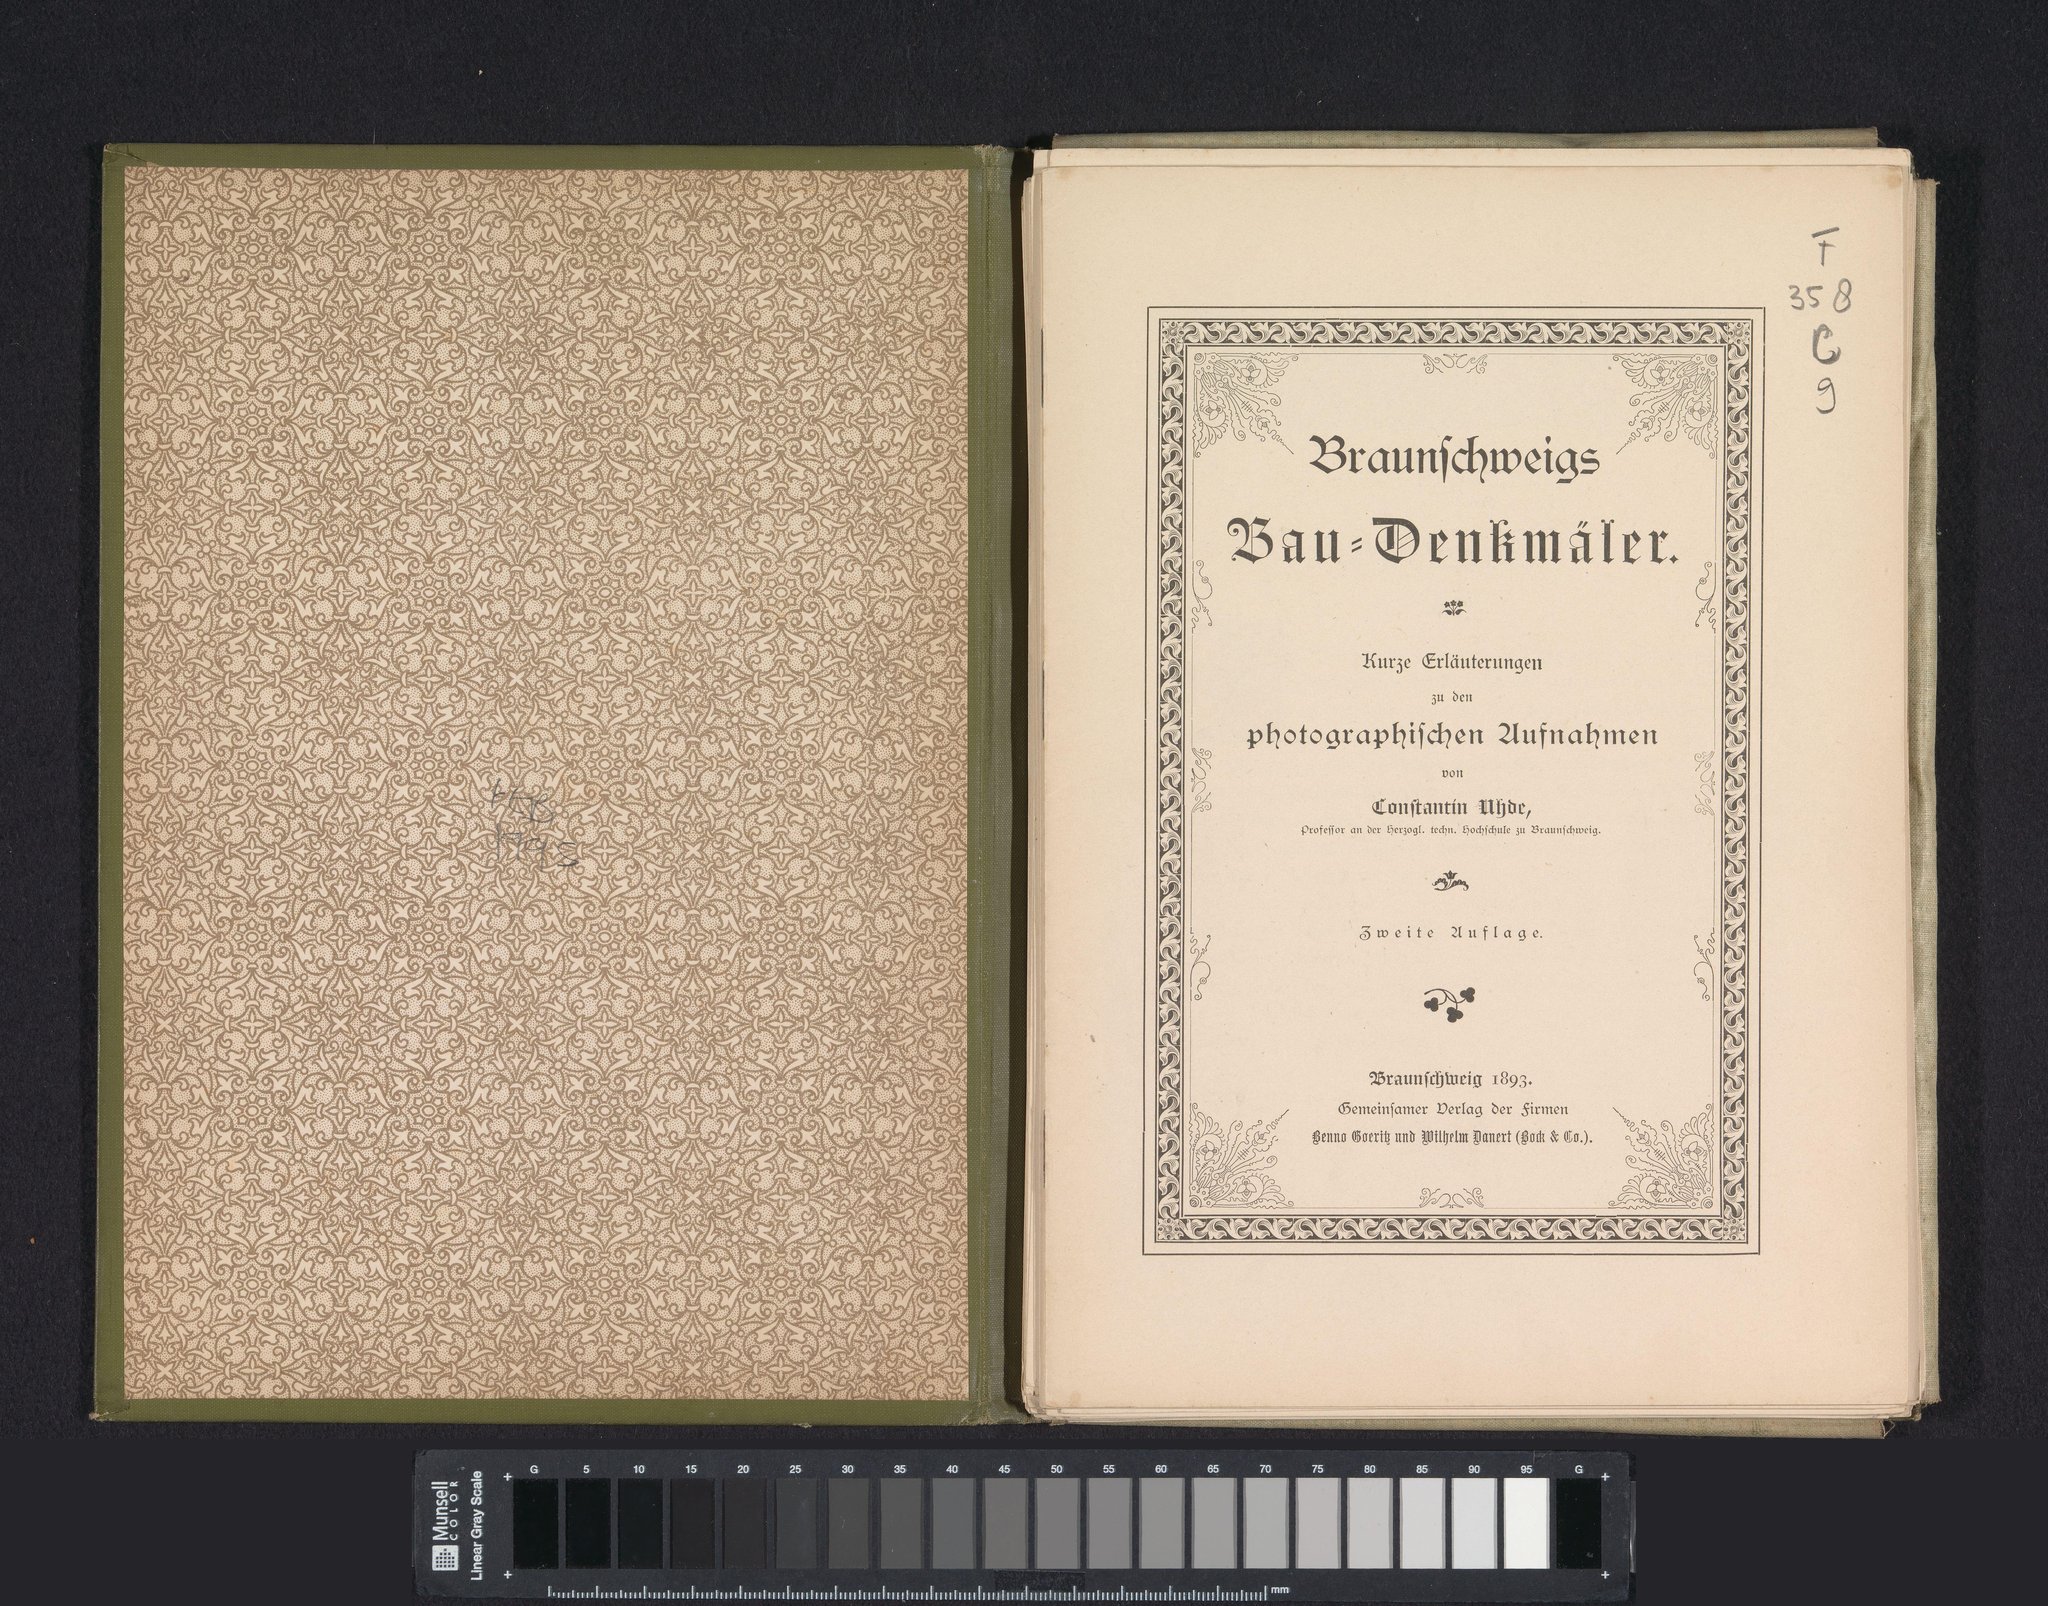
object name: page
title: Braunschweigs Bau- und Denkmäler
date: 1893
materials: cardboard, linen, paper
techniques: photograph, printing